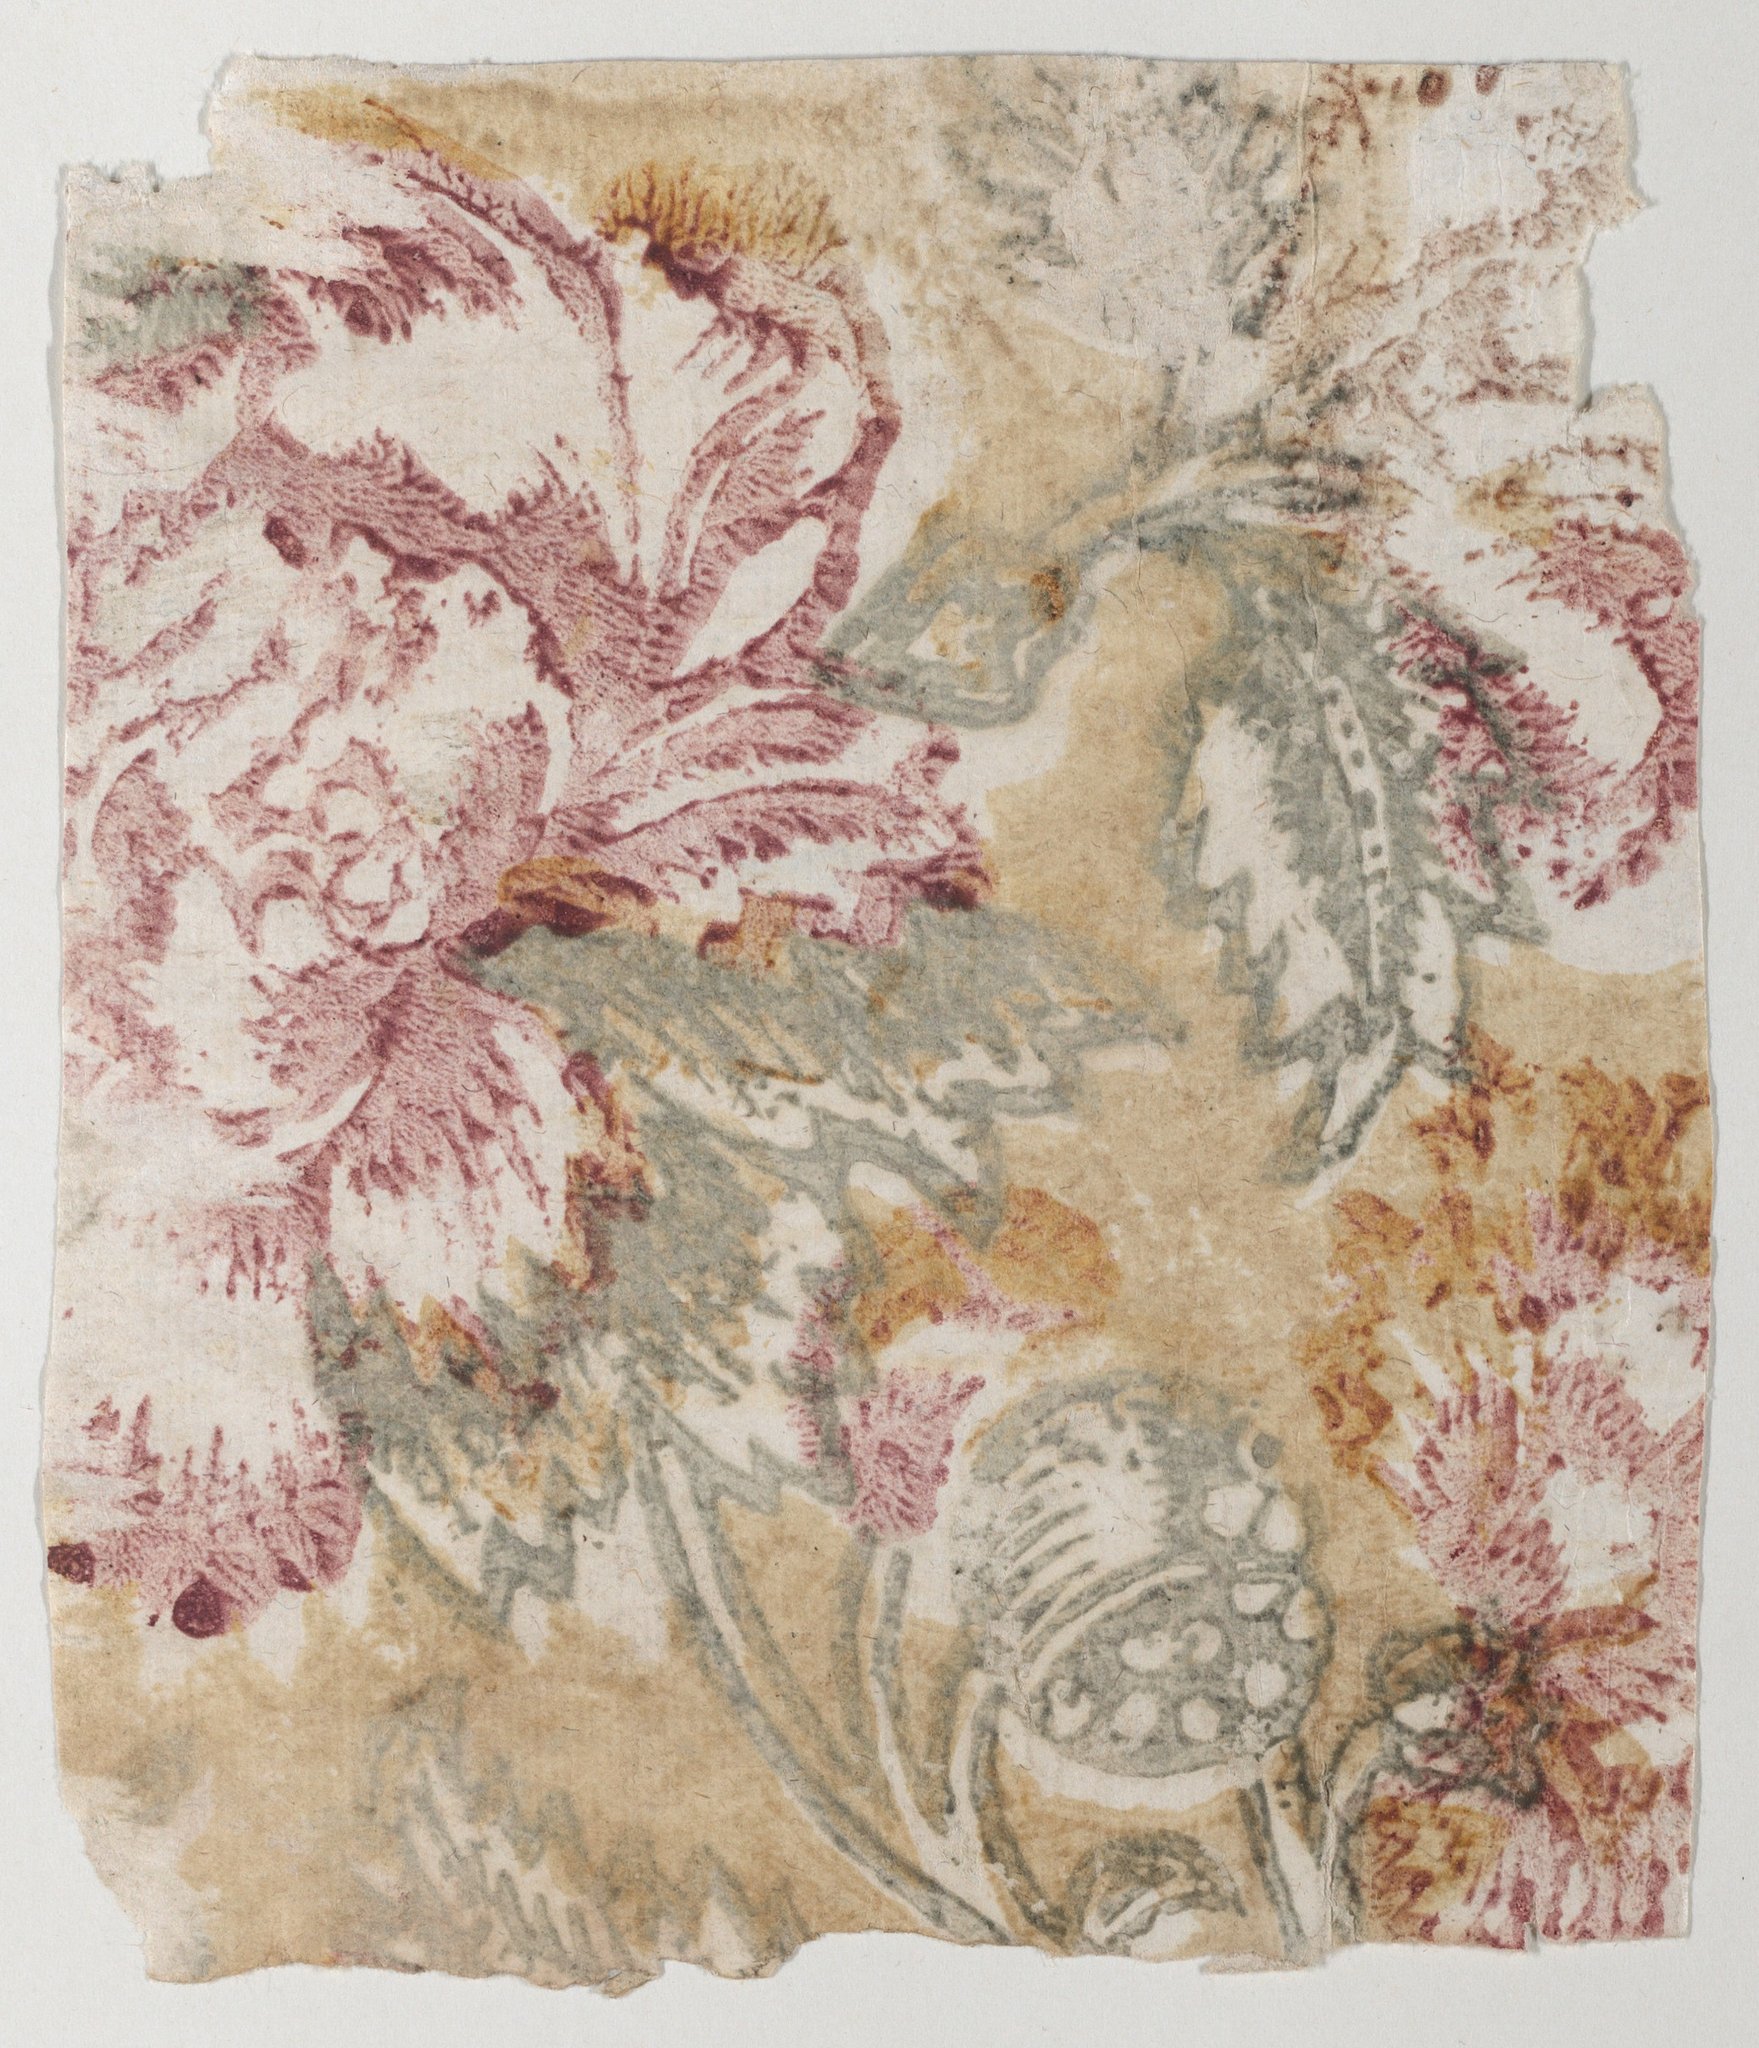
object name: print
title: Sheet with floral pattern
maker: Anonymous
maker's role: artist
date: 1701-1800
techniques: relief print